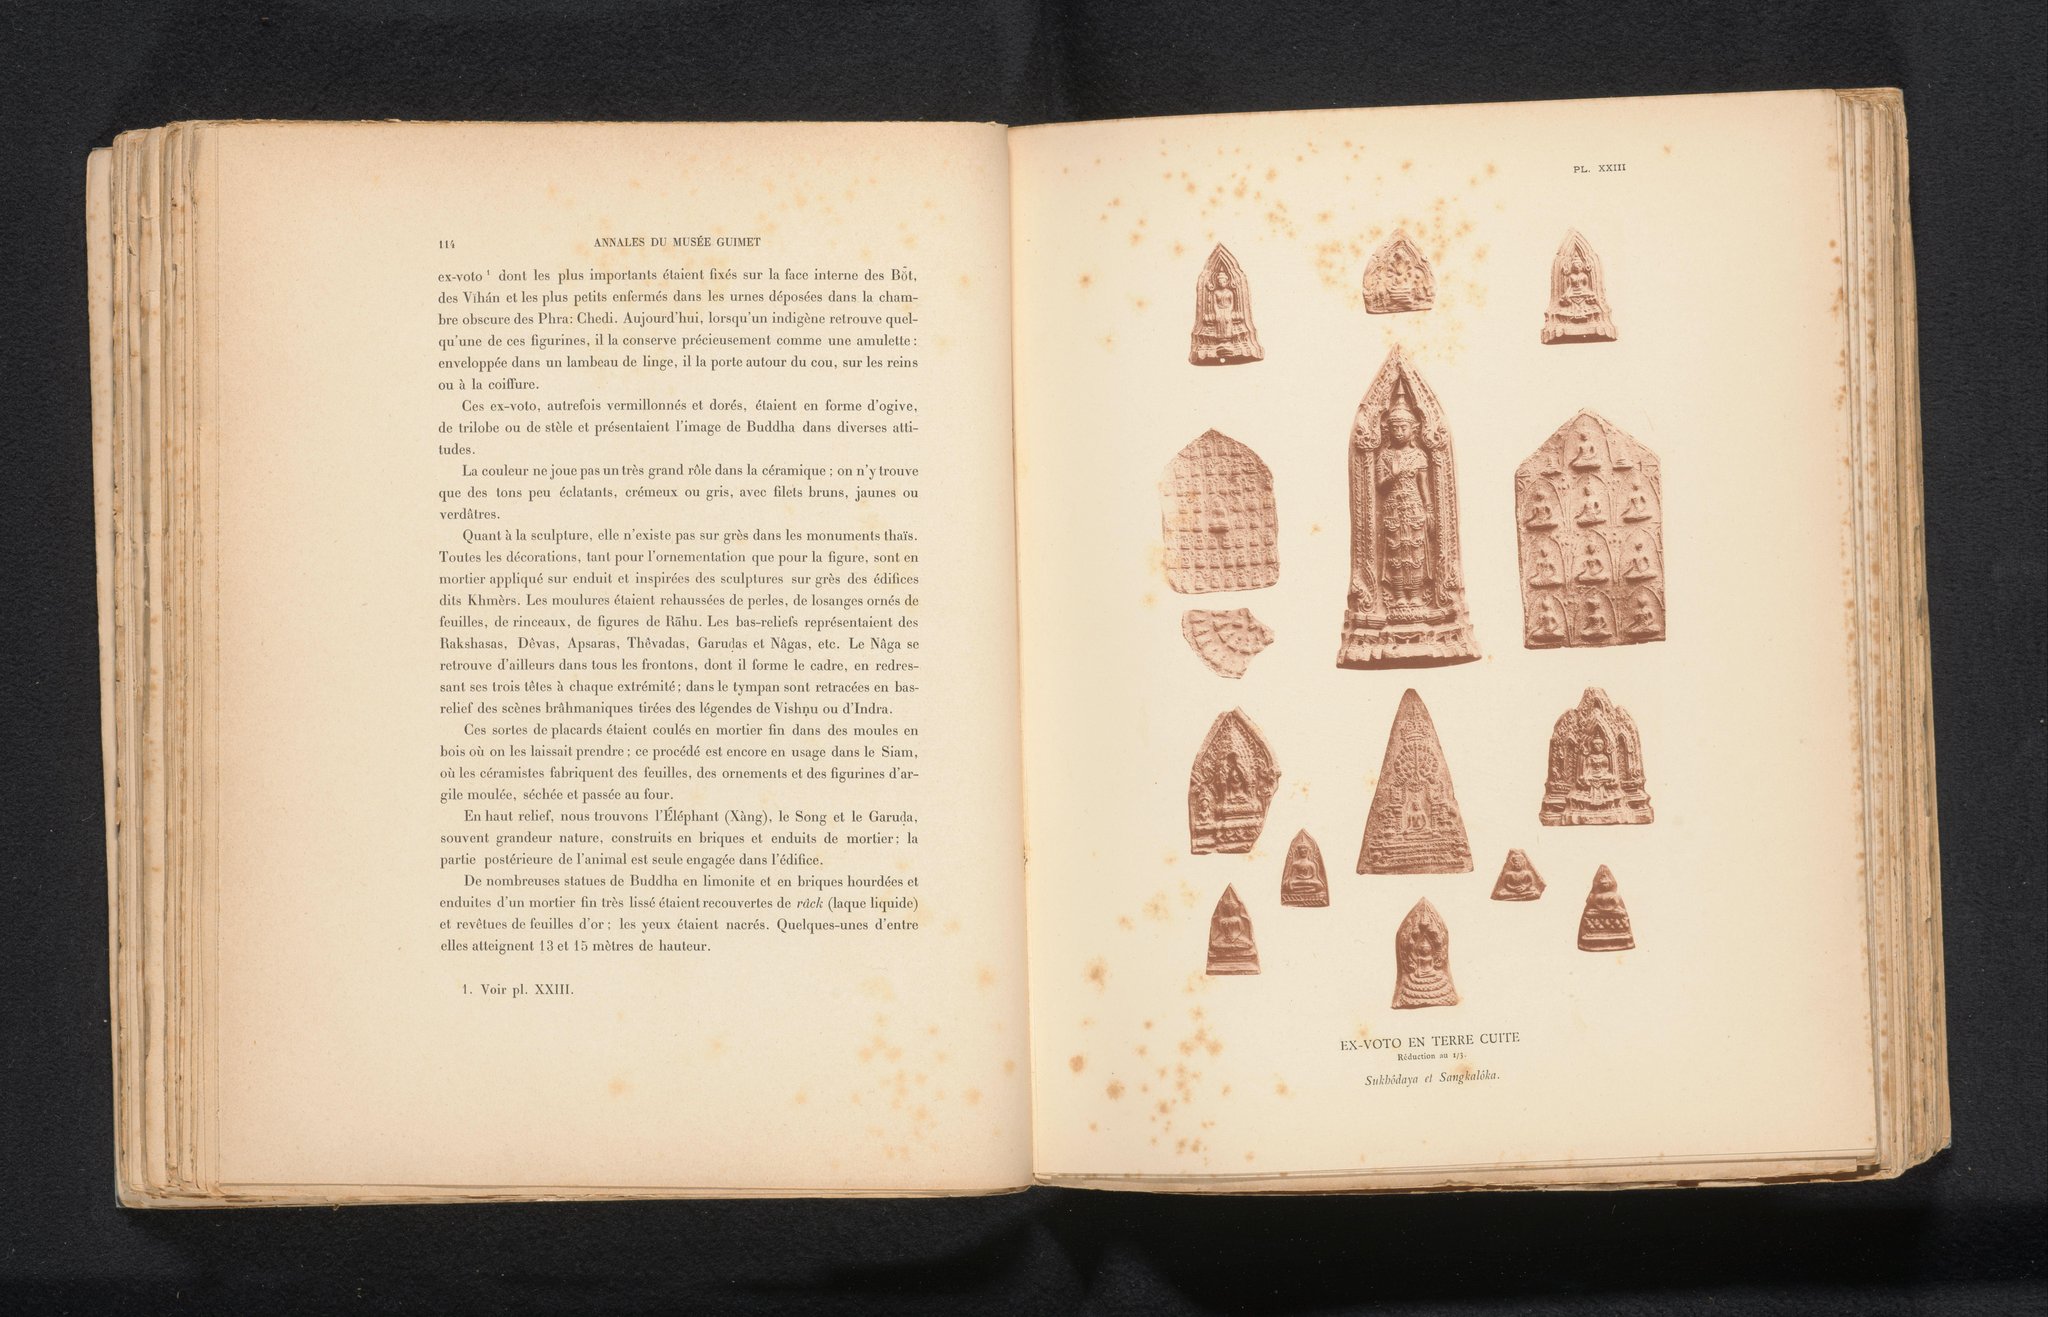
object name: page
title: Fragmenten met afbeeldingen van Boeddha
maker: Anonymous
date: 1890-1895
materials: paper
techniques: photograph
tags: ritual objects and ritual means ~ hinduism, buddhism, jainism, hinduism, buddhism, jainism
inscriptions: collector's mark: ‘Société d'Emulation de l'Ain/ Bourg/ Bibliothèque’, inscription: ‘Réduction au 1/3./ Sukhôdaya et Sangkalóka’, inscription: ‘Pl. XXIII’